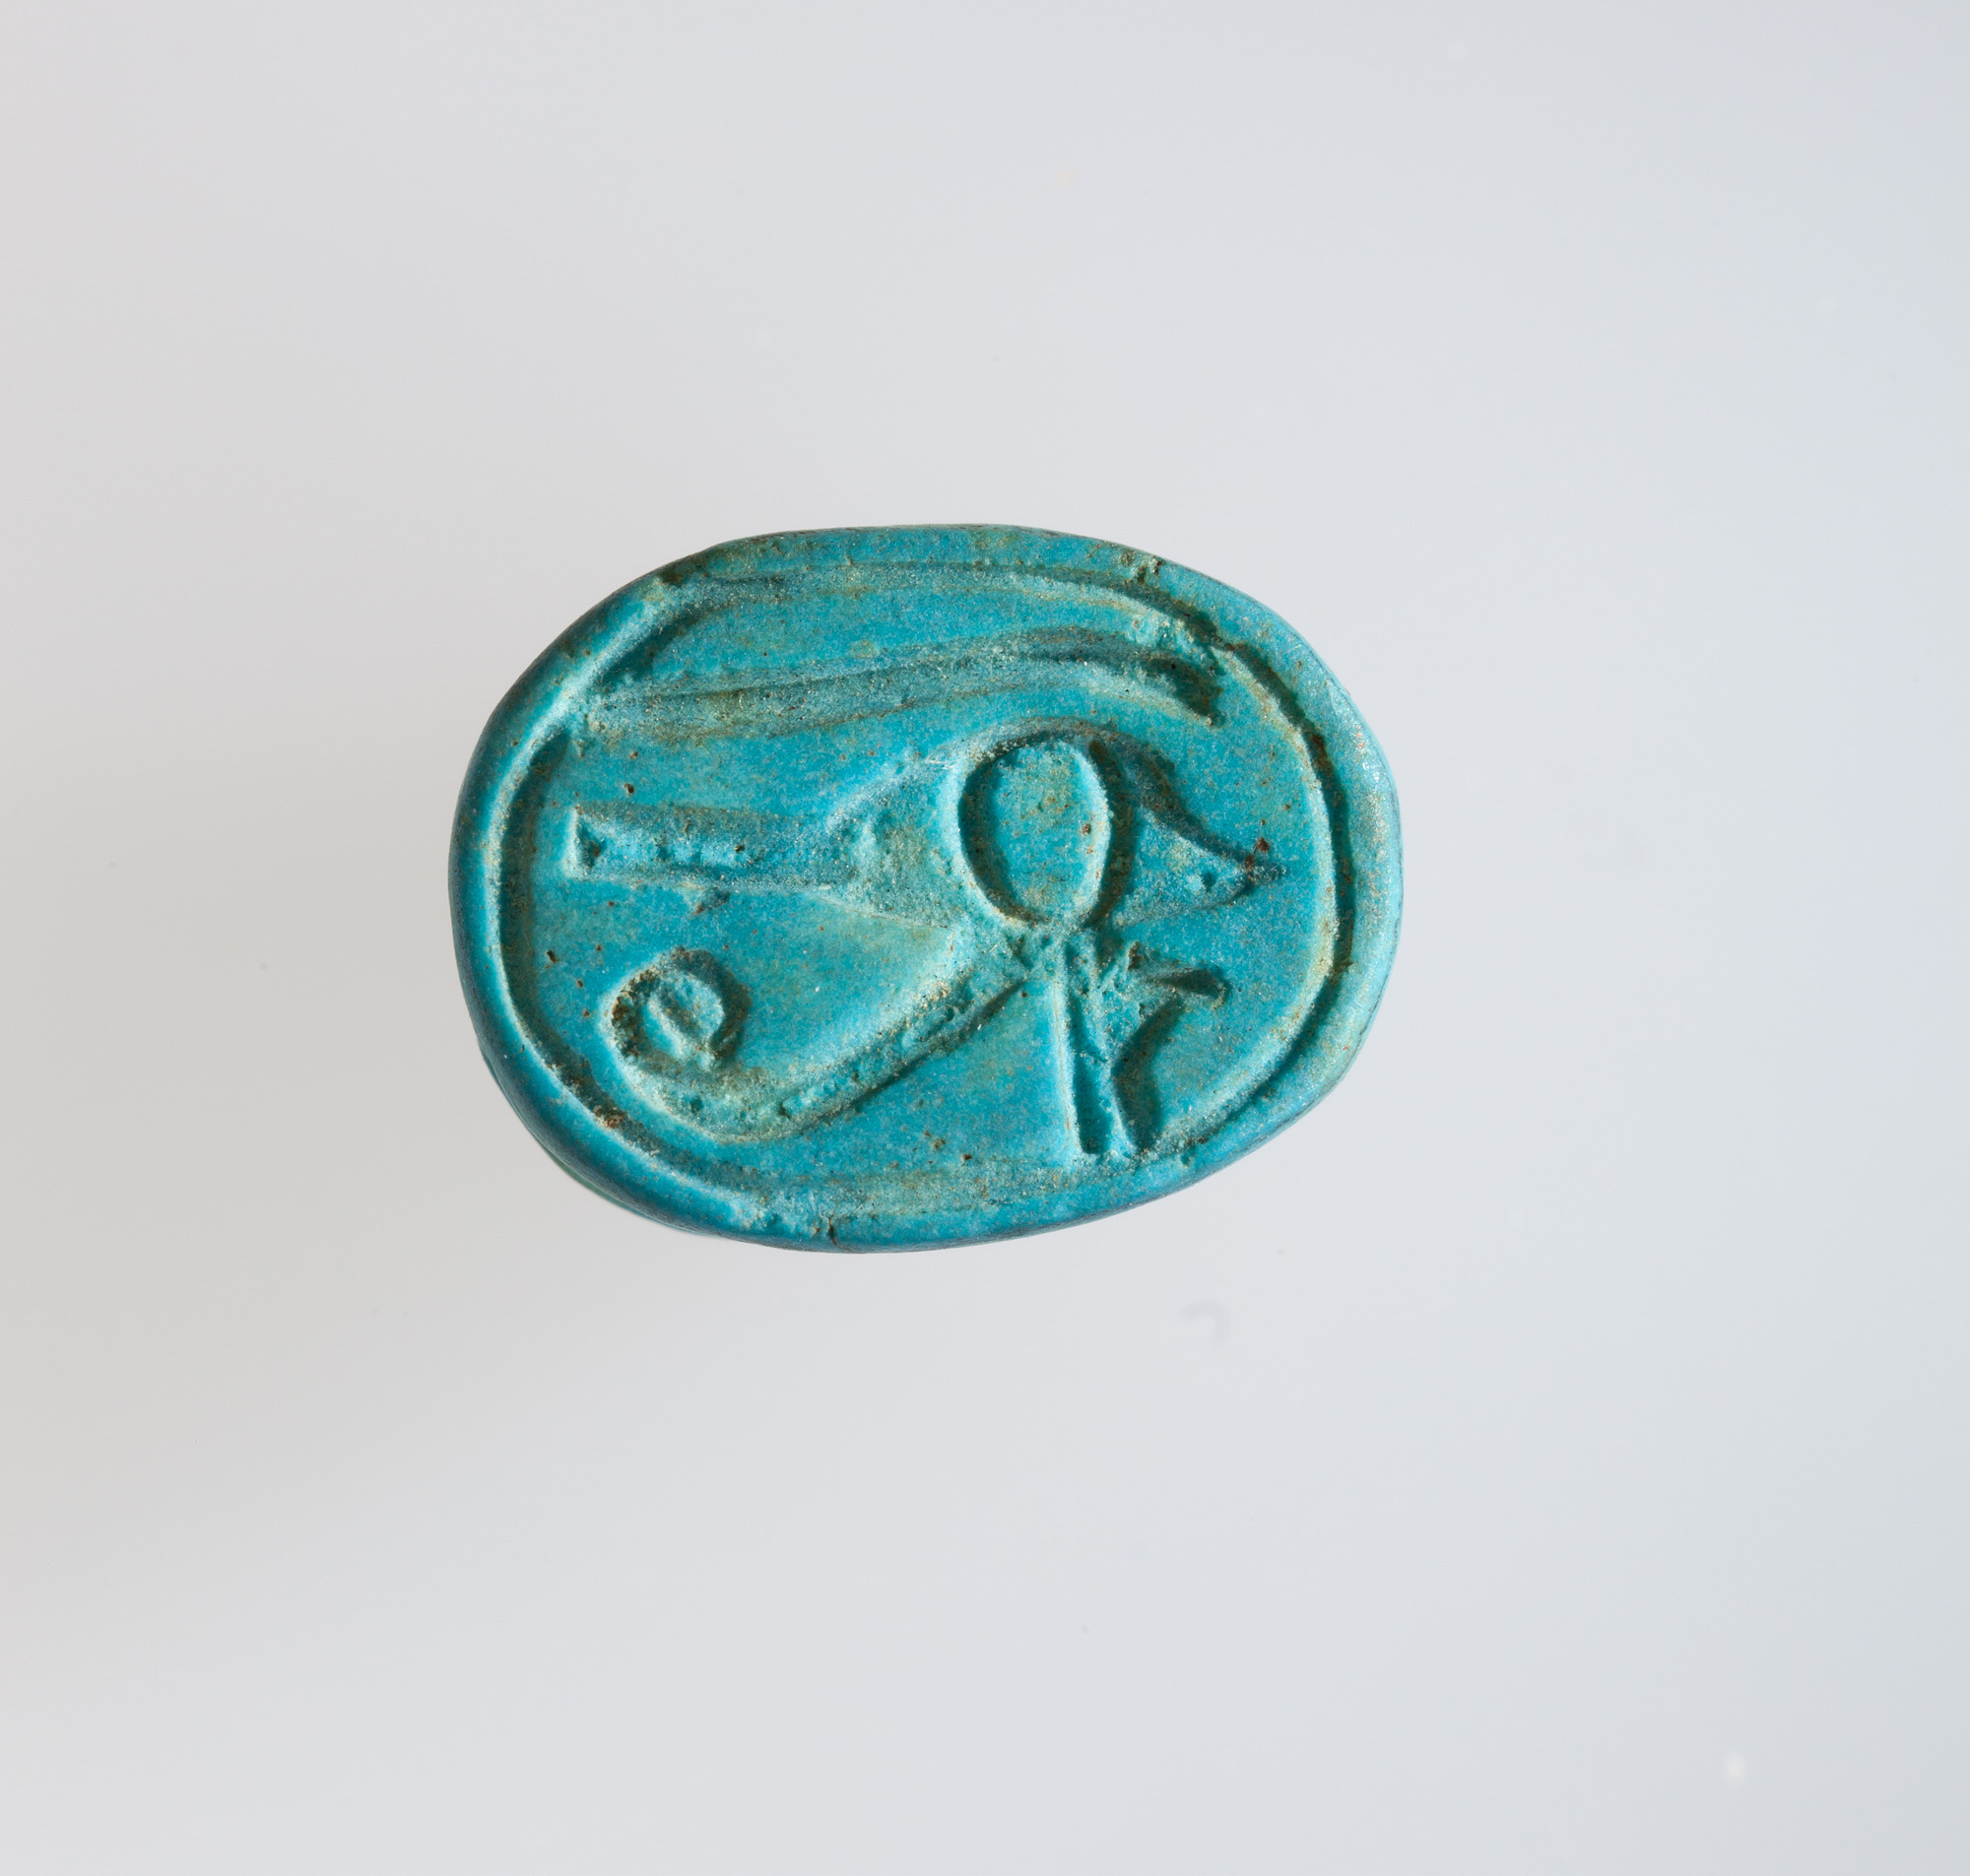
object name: scarab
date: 1479-1458 BCE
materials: faience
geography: egypt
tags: scarabs